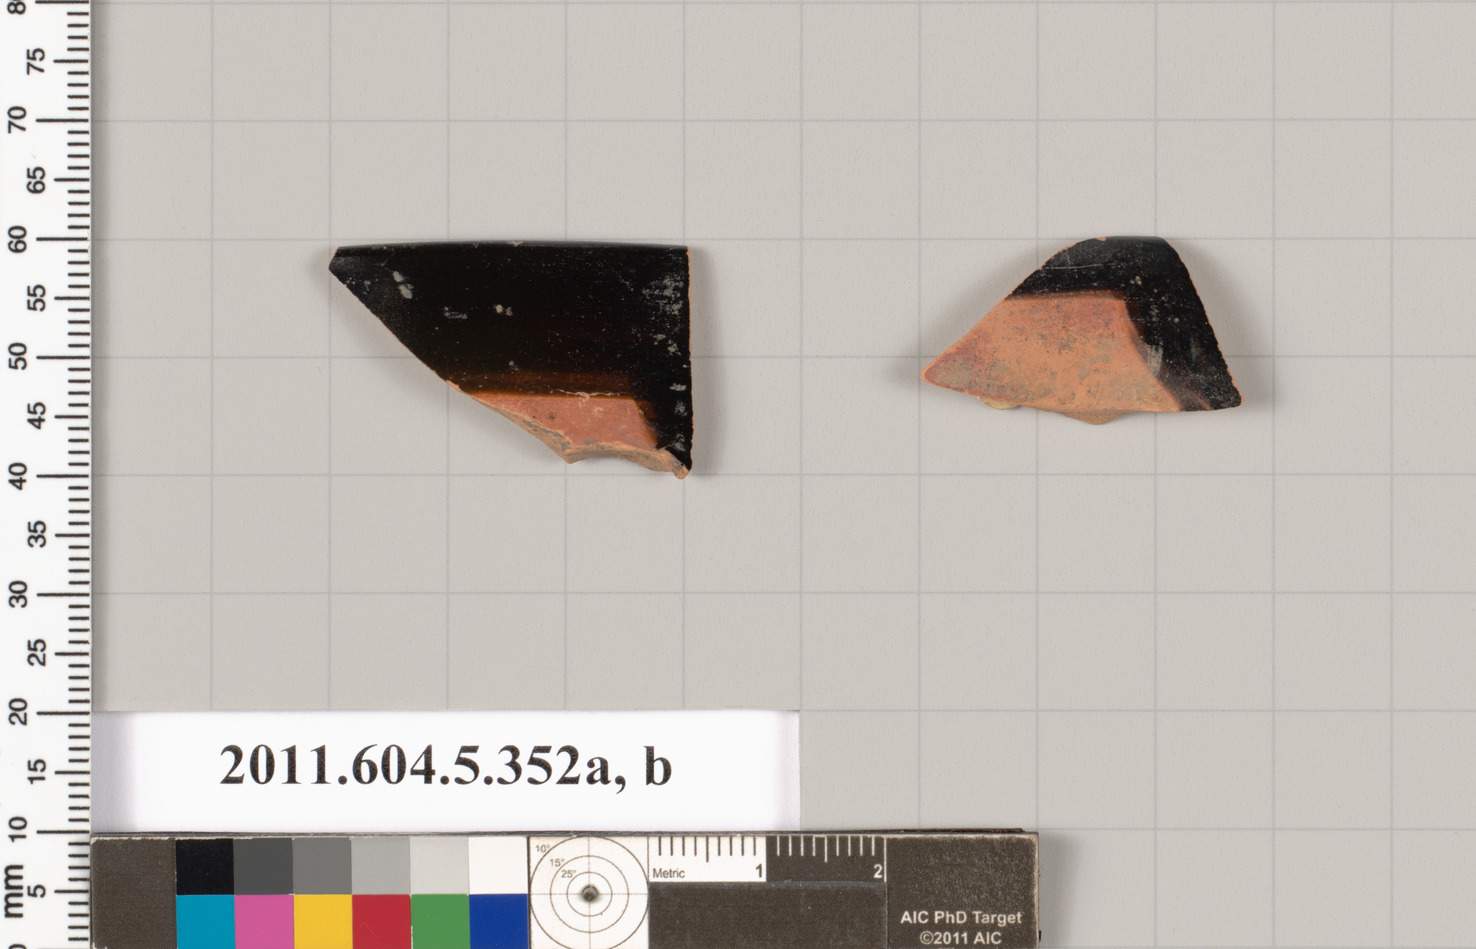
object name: kylix fragment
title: Terracotta rim fragments of kylikes (drinking cups)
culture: greek, attic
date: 600-401 BCE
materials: terracotta